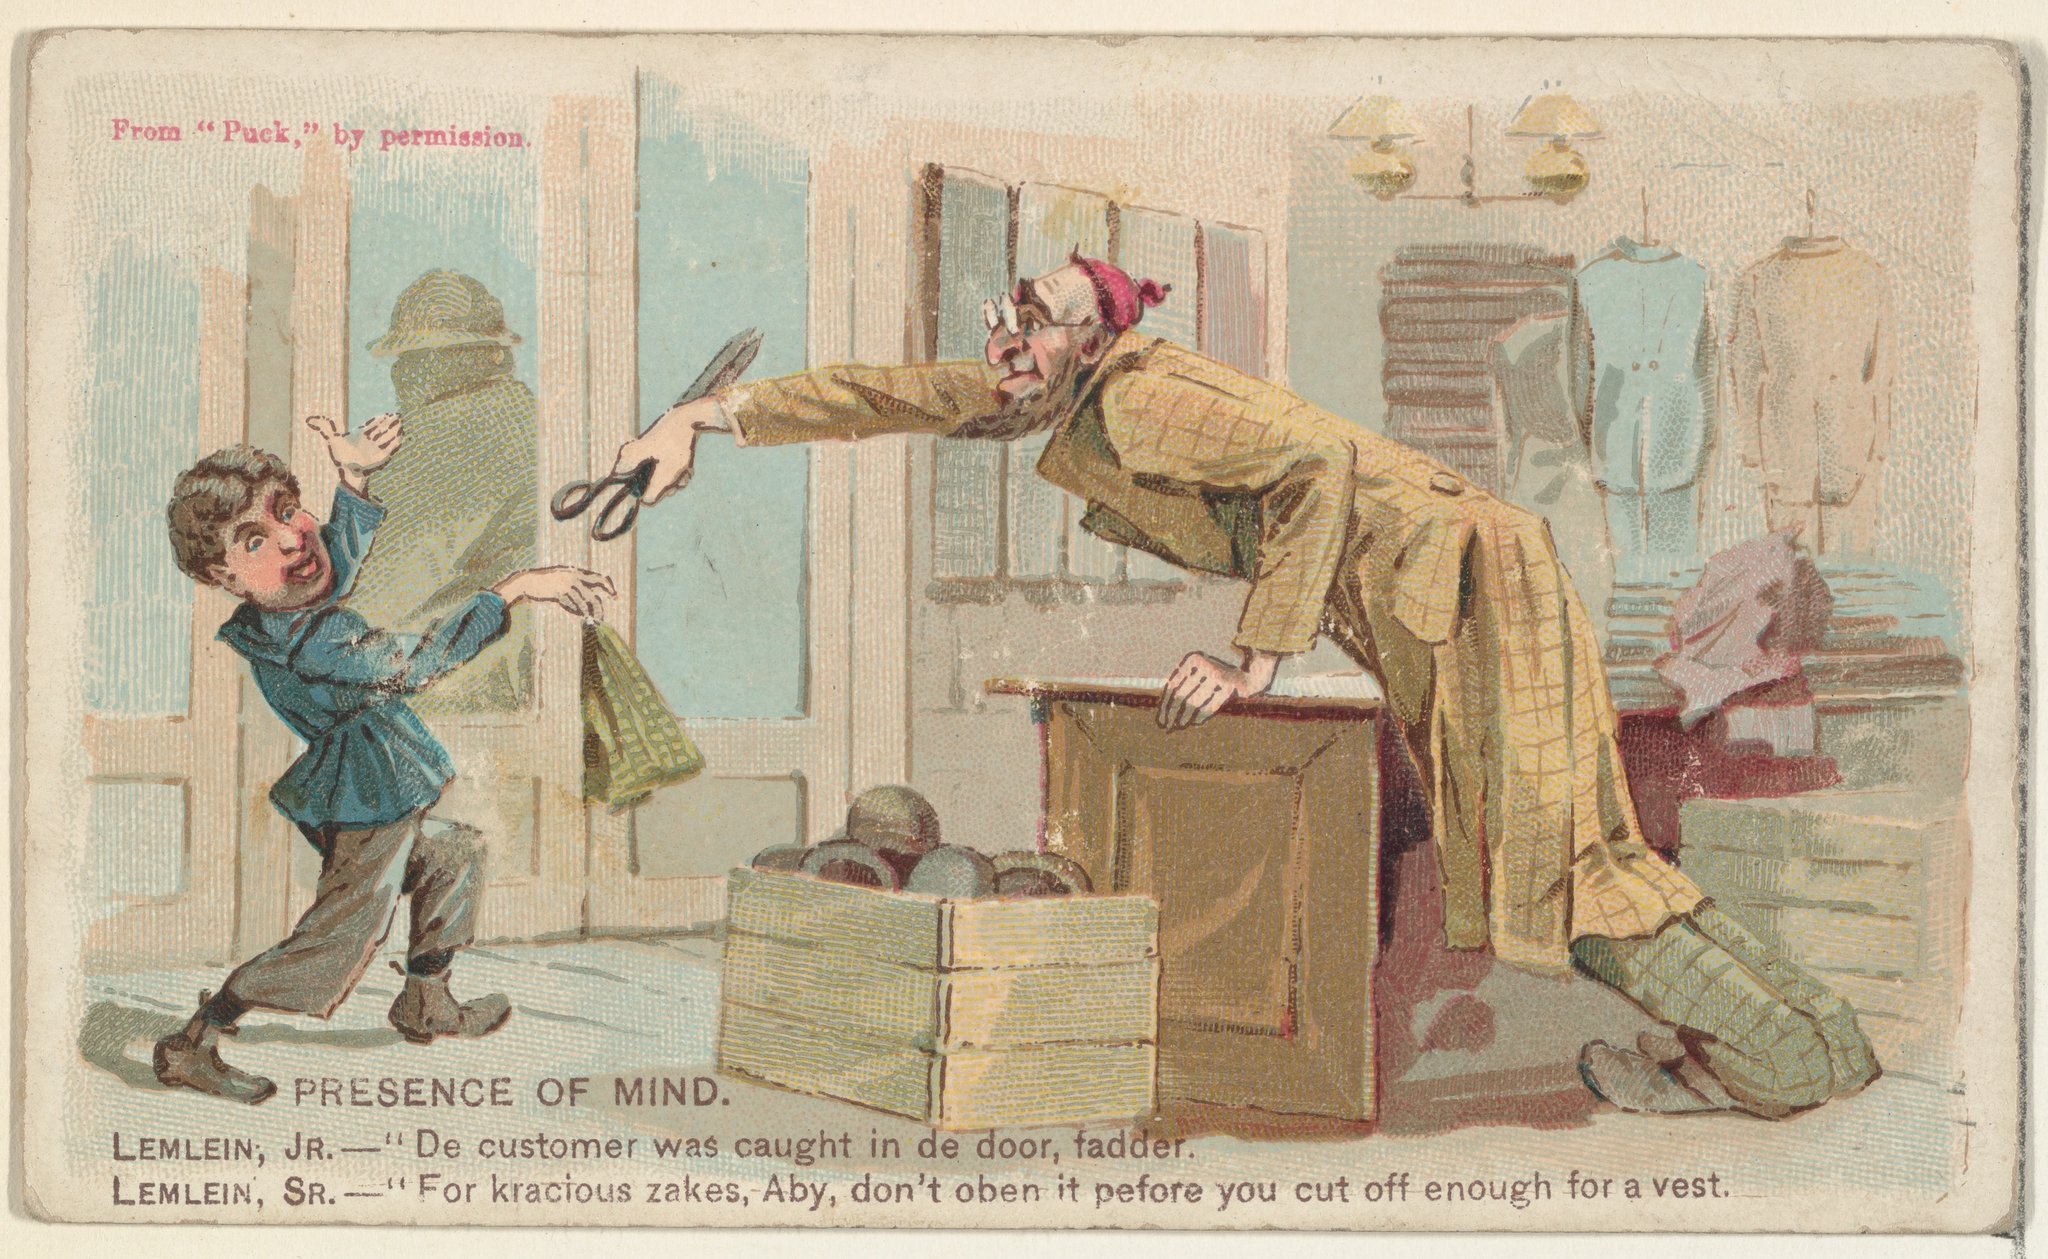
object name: print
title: Presence of Mind, from the Snapshots from "Puck" series (N128) issued by Duke Sons & Co. to promote Honest Long Cut Tobacco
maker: w. duke, sons & co.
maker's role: publisher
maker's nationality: american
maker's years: 1870-1920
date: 1888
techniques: color lithograph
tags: satire,boys,men